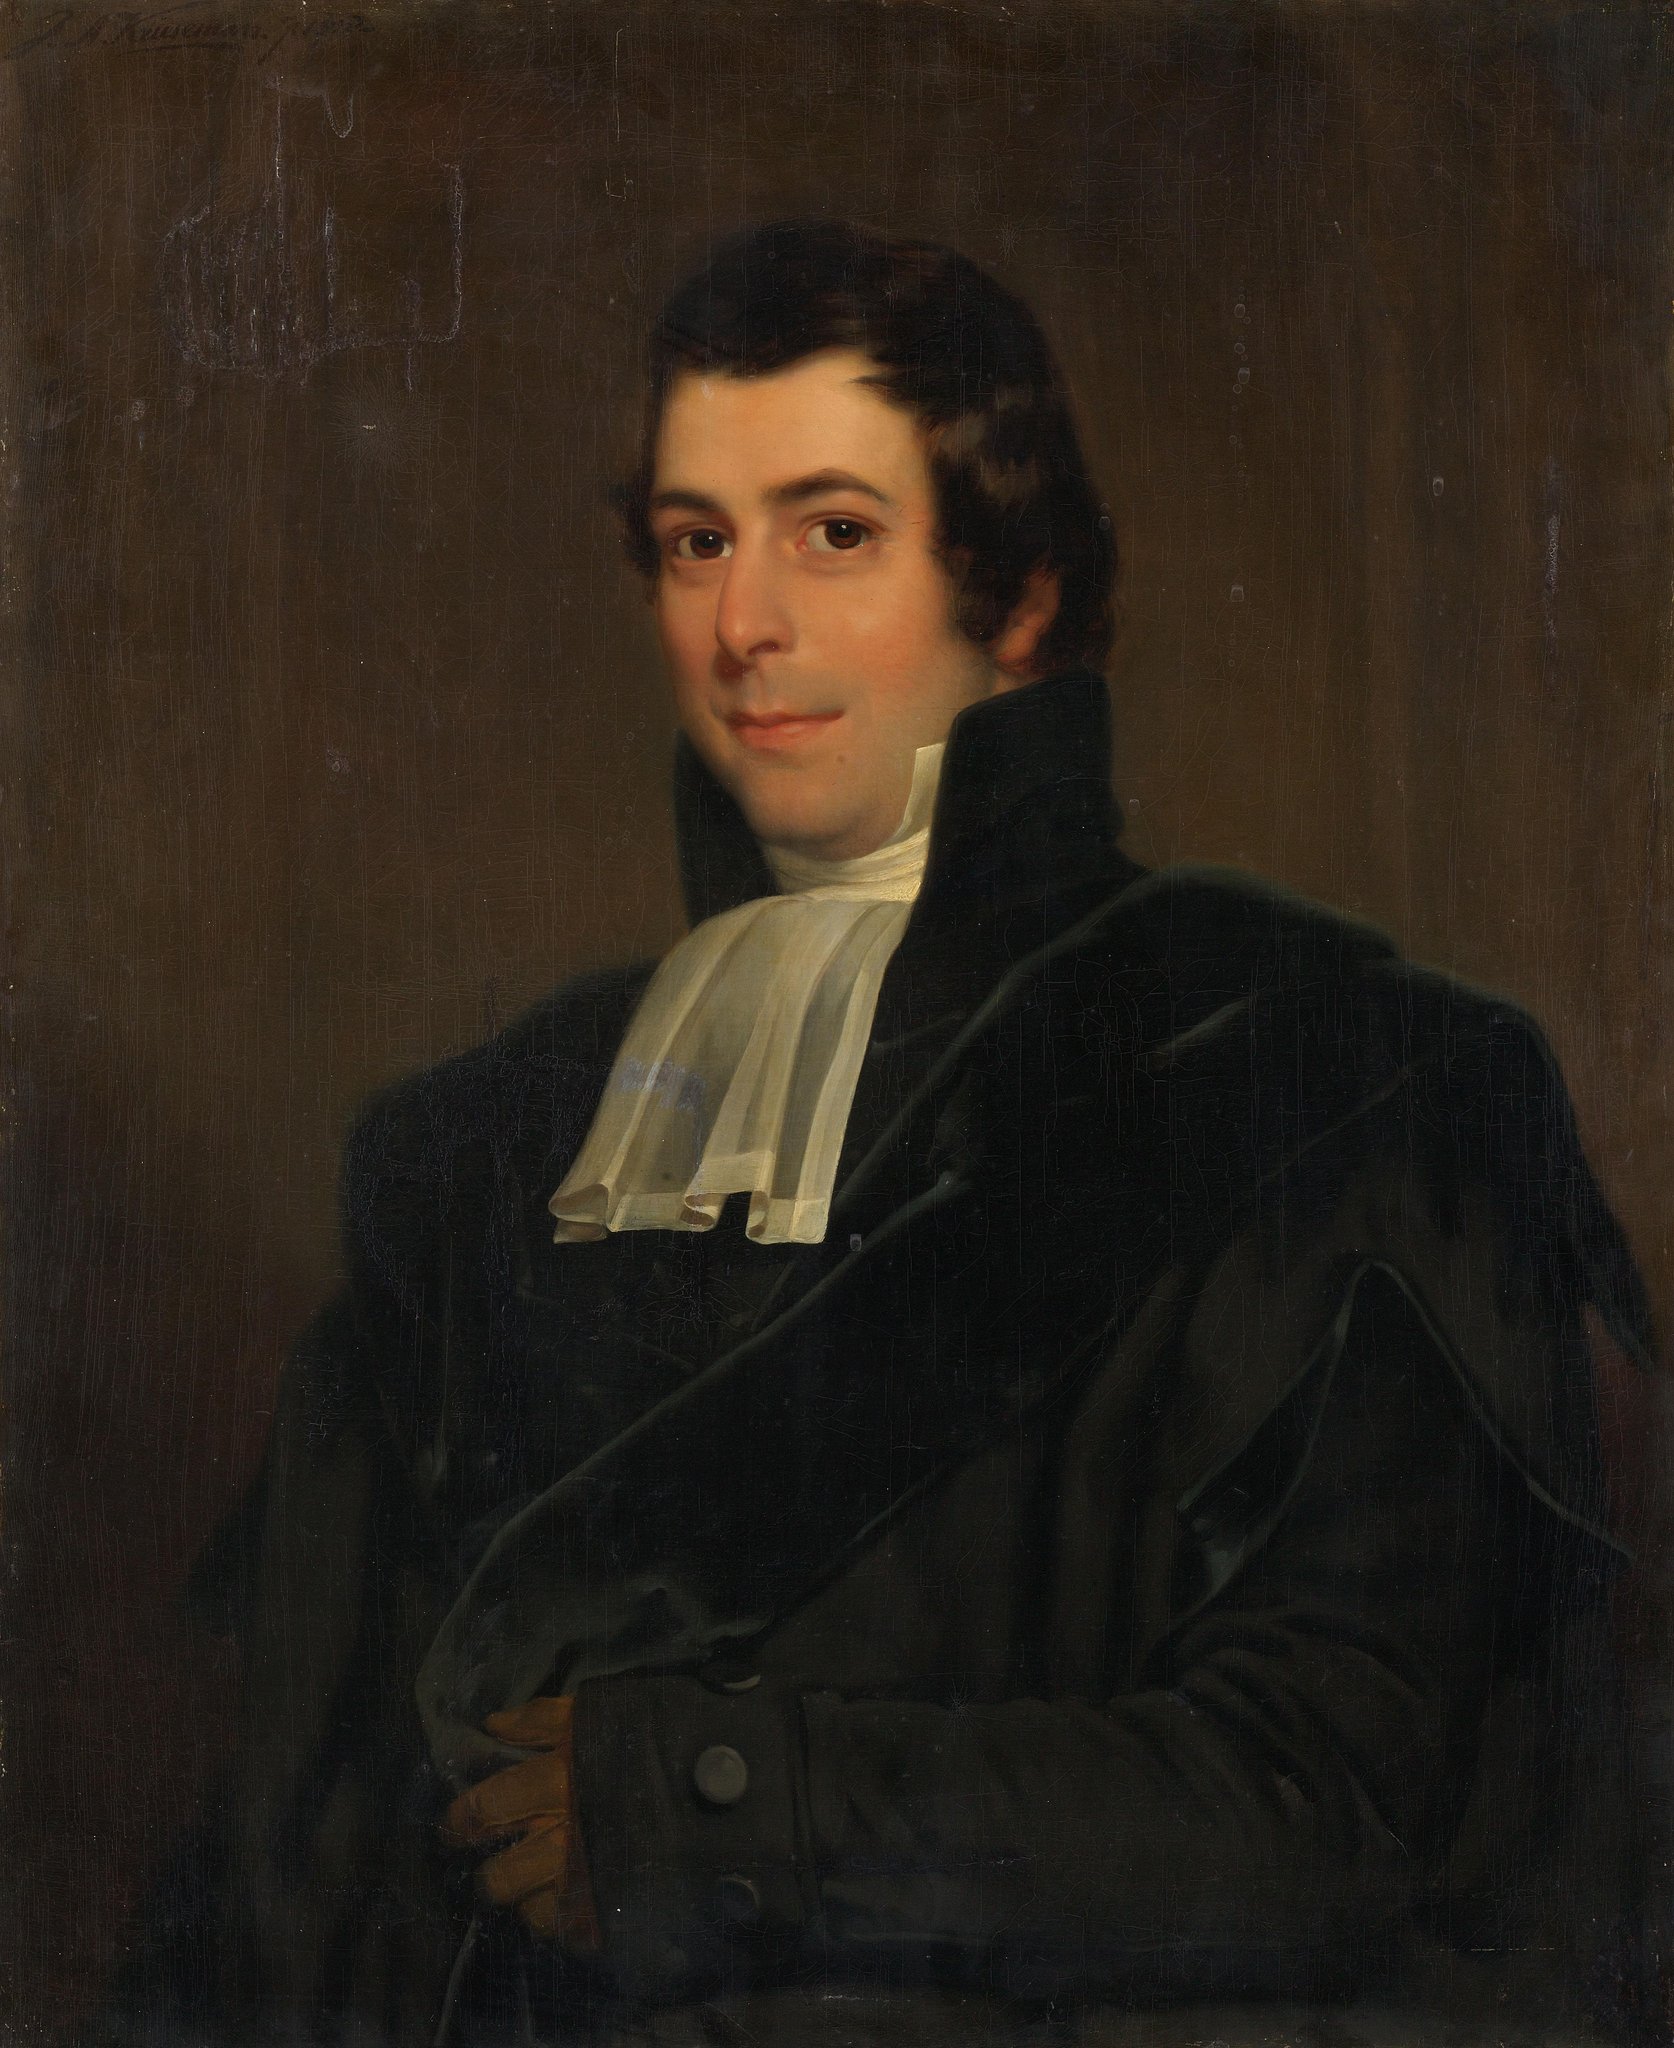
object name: painting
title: Gijsbertus Johannes Rooyens (1785-1846), Professor of Theology and Church History at the University of Amsterdam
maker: jan adam kruseman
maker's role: draughtsman, painter, print maker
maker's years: 1804-1862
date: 1828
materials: canvas, oil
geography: netherlands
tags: den bosch, theologian, historical persons, professor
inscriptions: signature and date: ‘J.A. Kruseman. ft 1828’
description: Portret van Gijsbertus Johannes Rooyens, sinds 1827 hoogleraar in de theologie en de kerkgeschiedenis te Amsterdam. Ten halven lijve, naar links, gekleed in een zwarte toga met witte bef.